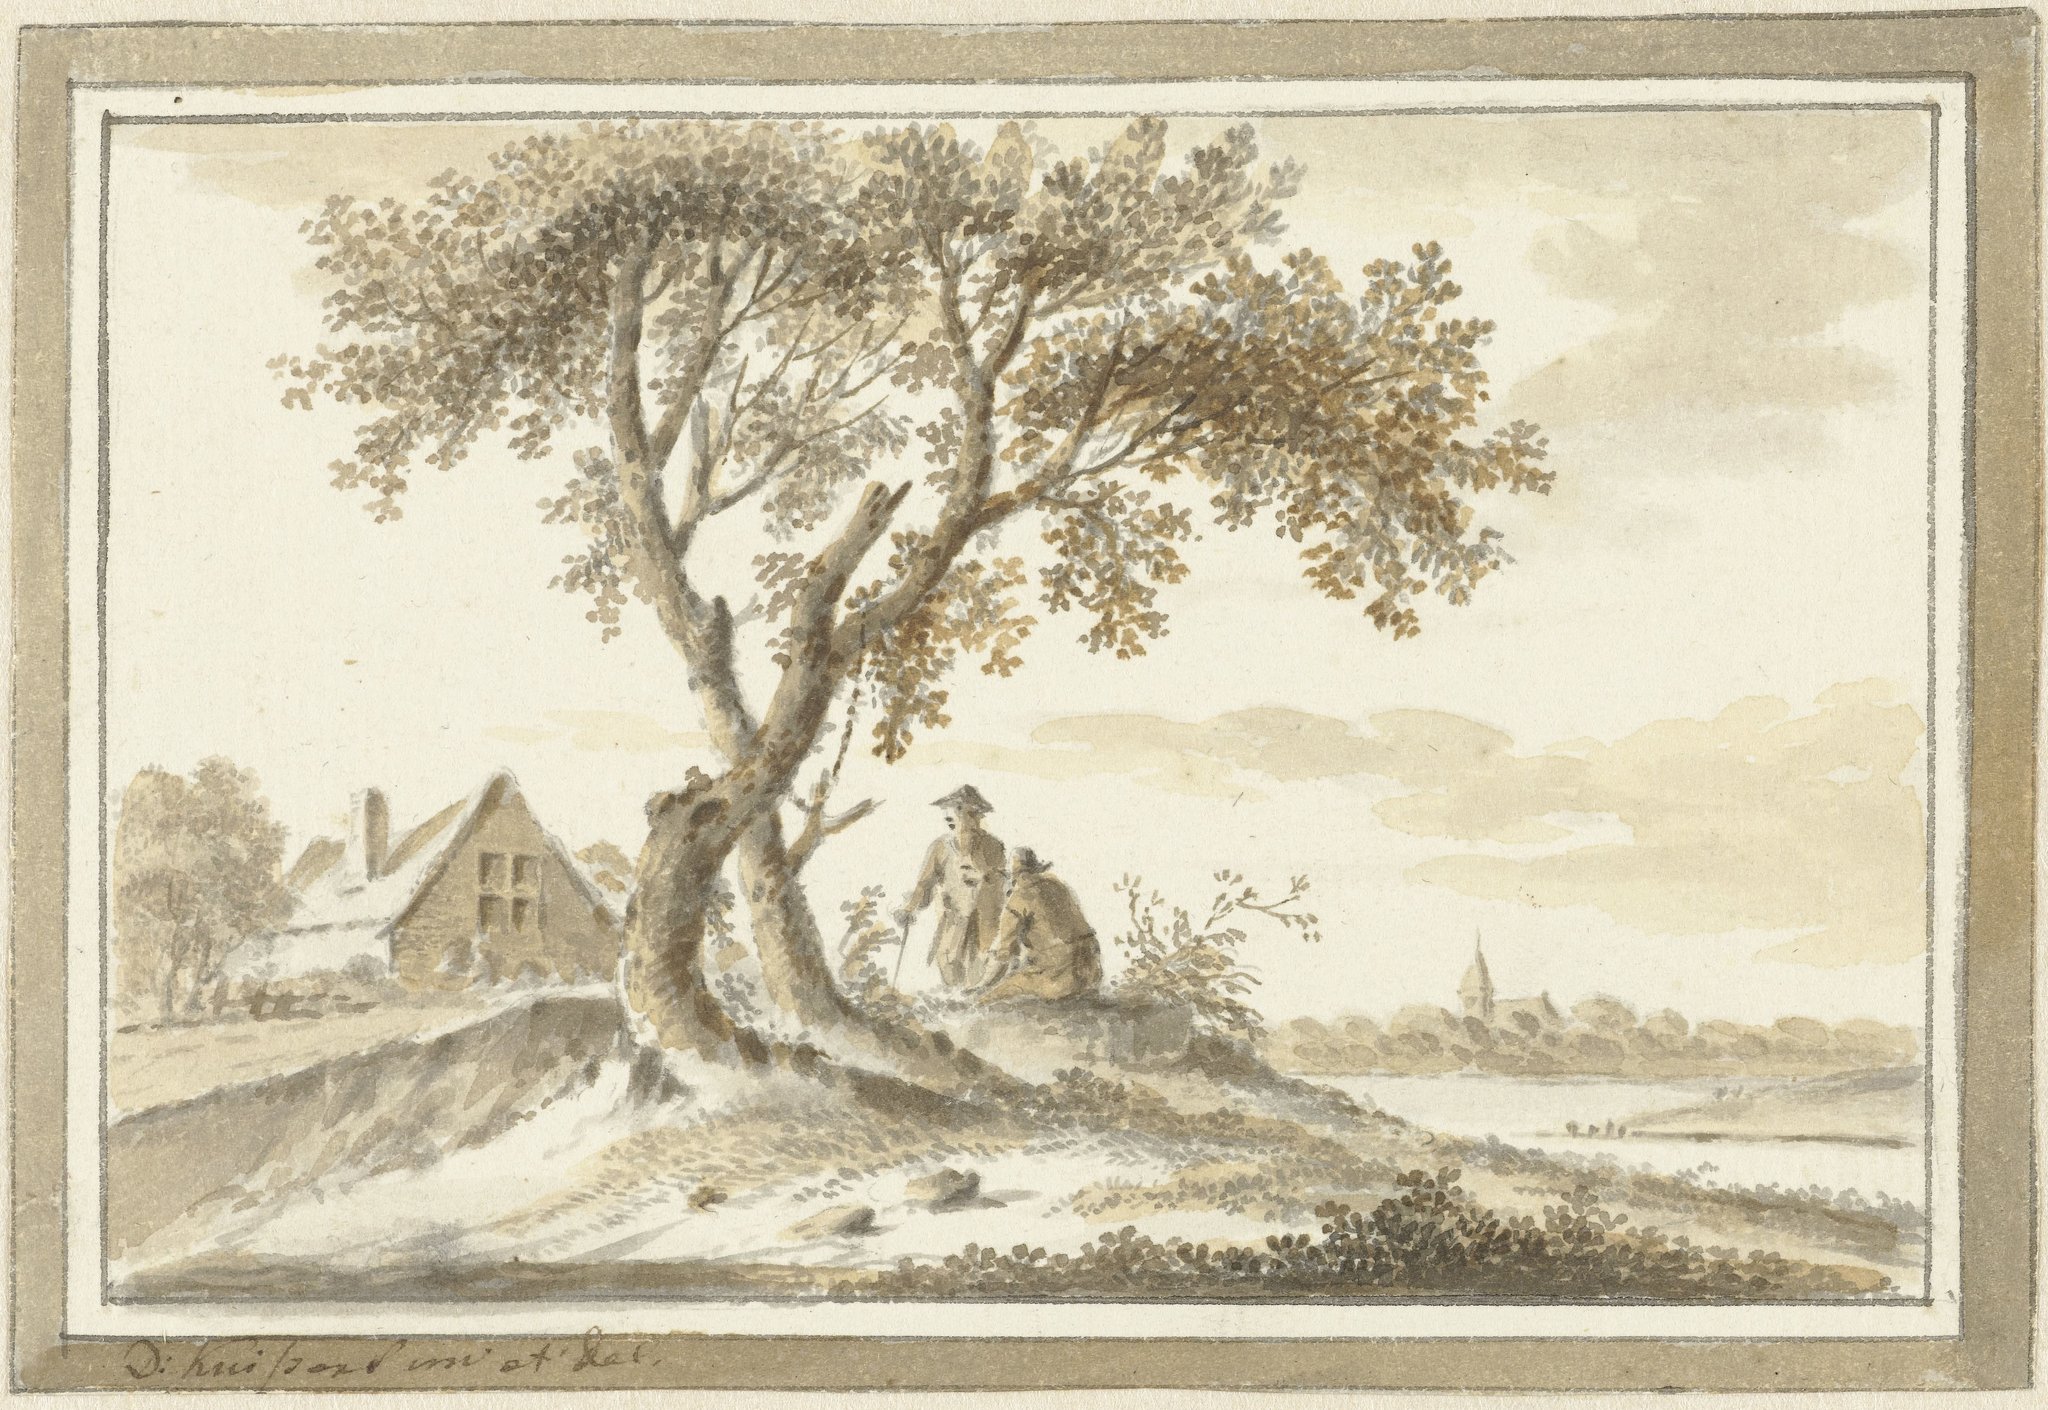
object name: drawing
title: Landschap met twee mannen onder een boom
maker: dirk kuipers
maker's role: draughtsman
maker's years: 1733-1796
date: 1743-1796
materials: paper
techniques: brush